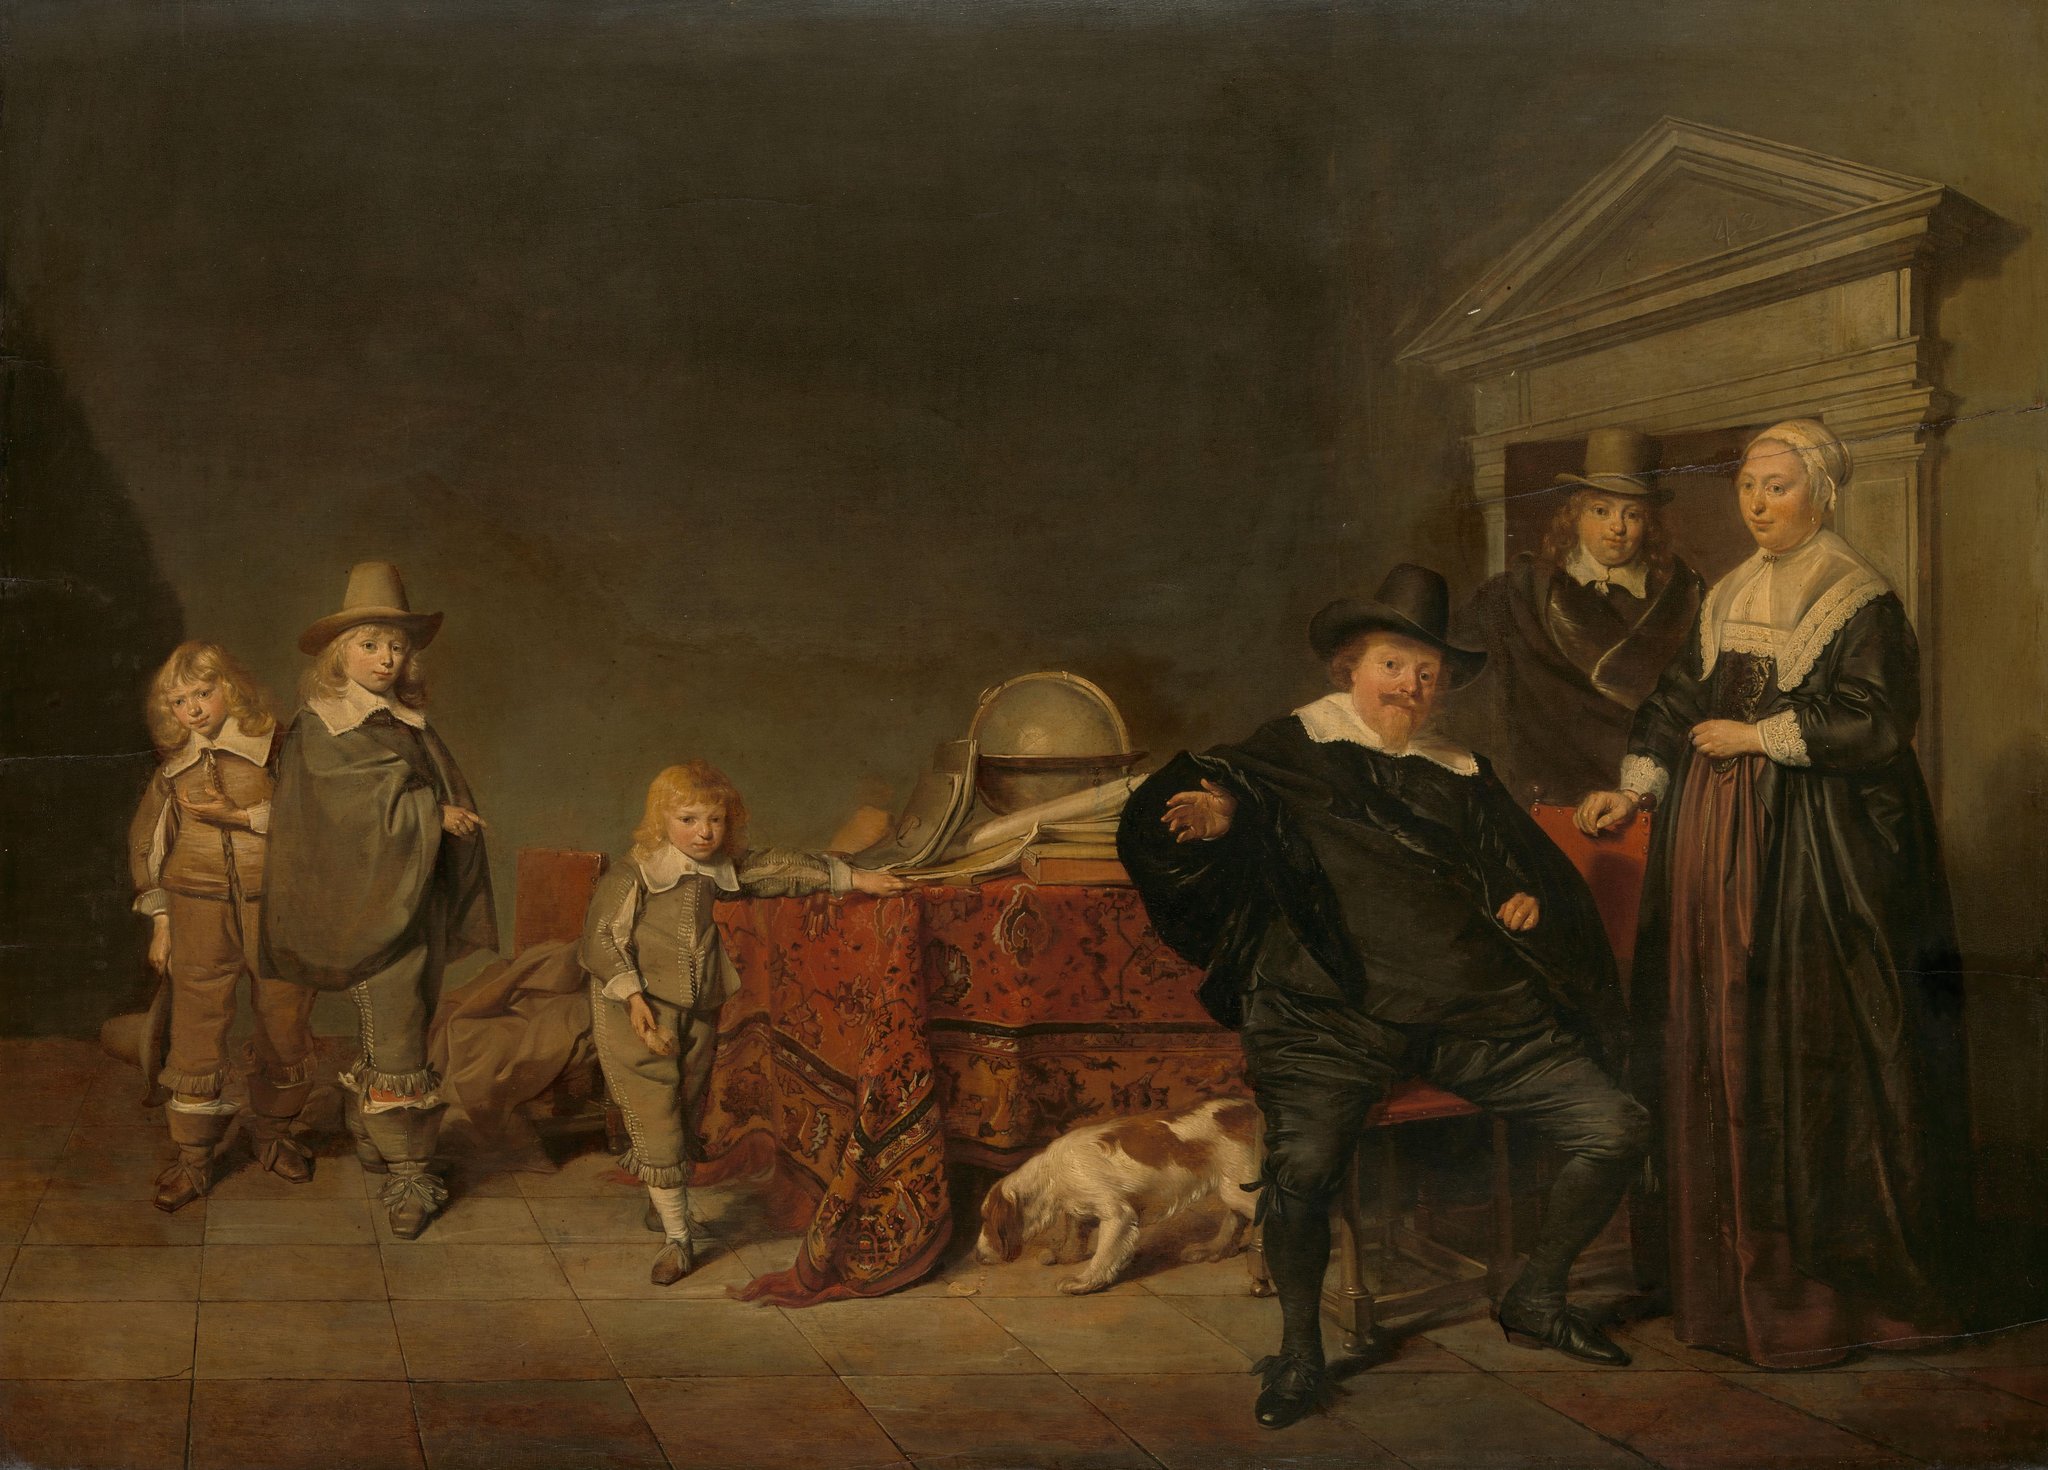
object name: painting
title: Family Group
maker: pieter codde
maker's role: painter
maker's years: 1599-1678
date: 1642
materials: oil, panel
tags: family life at home, anonymous historical persons portrayed in a group, in a group-portrait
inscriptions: signature, in ligated monogram, on one of the books on the table: ‘PC’, date, above the door: ‘1642’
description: Groepsportret van een familie. Rechts de ouders en de oudste zoon, links drie jongere zonen. In het midden een tafel met boeken en een globe. Een hond snuffelt aan een tafelpoot.